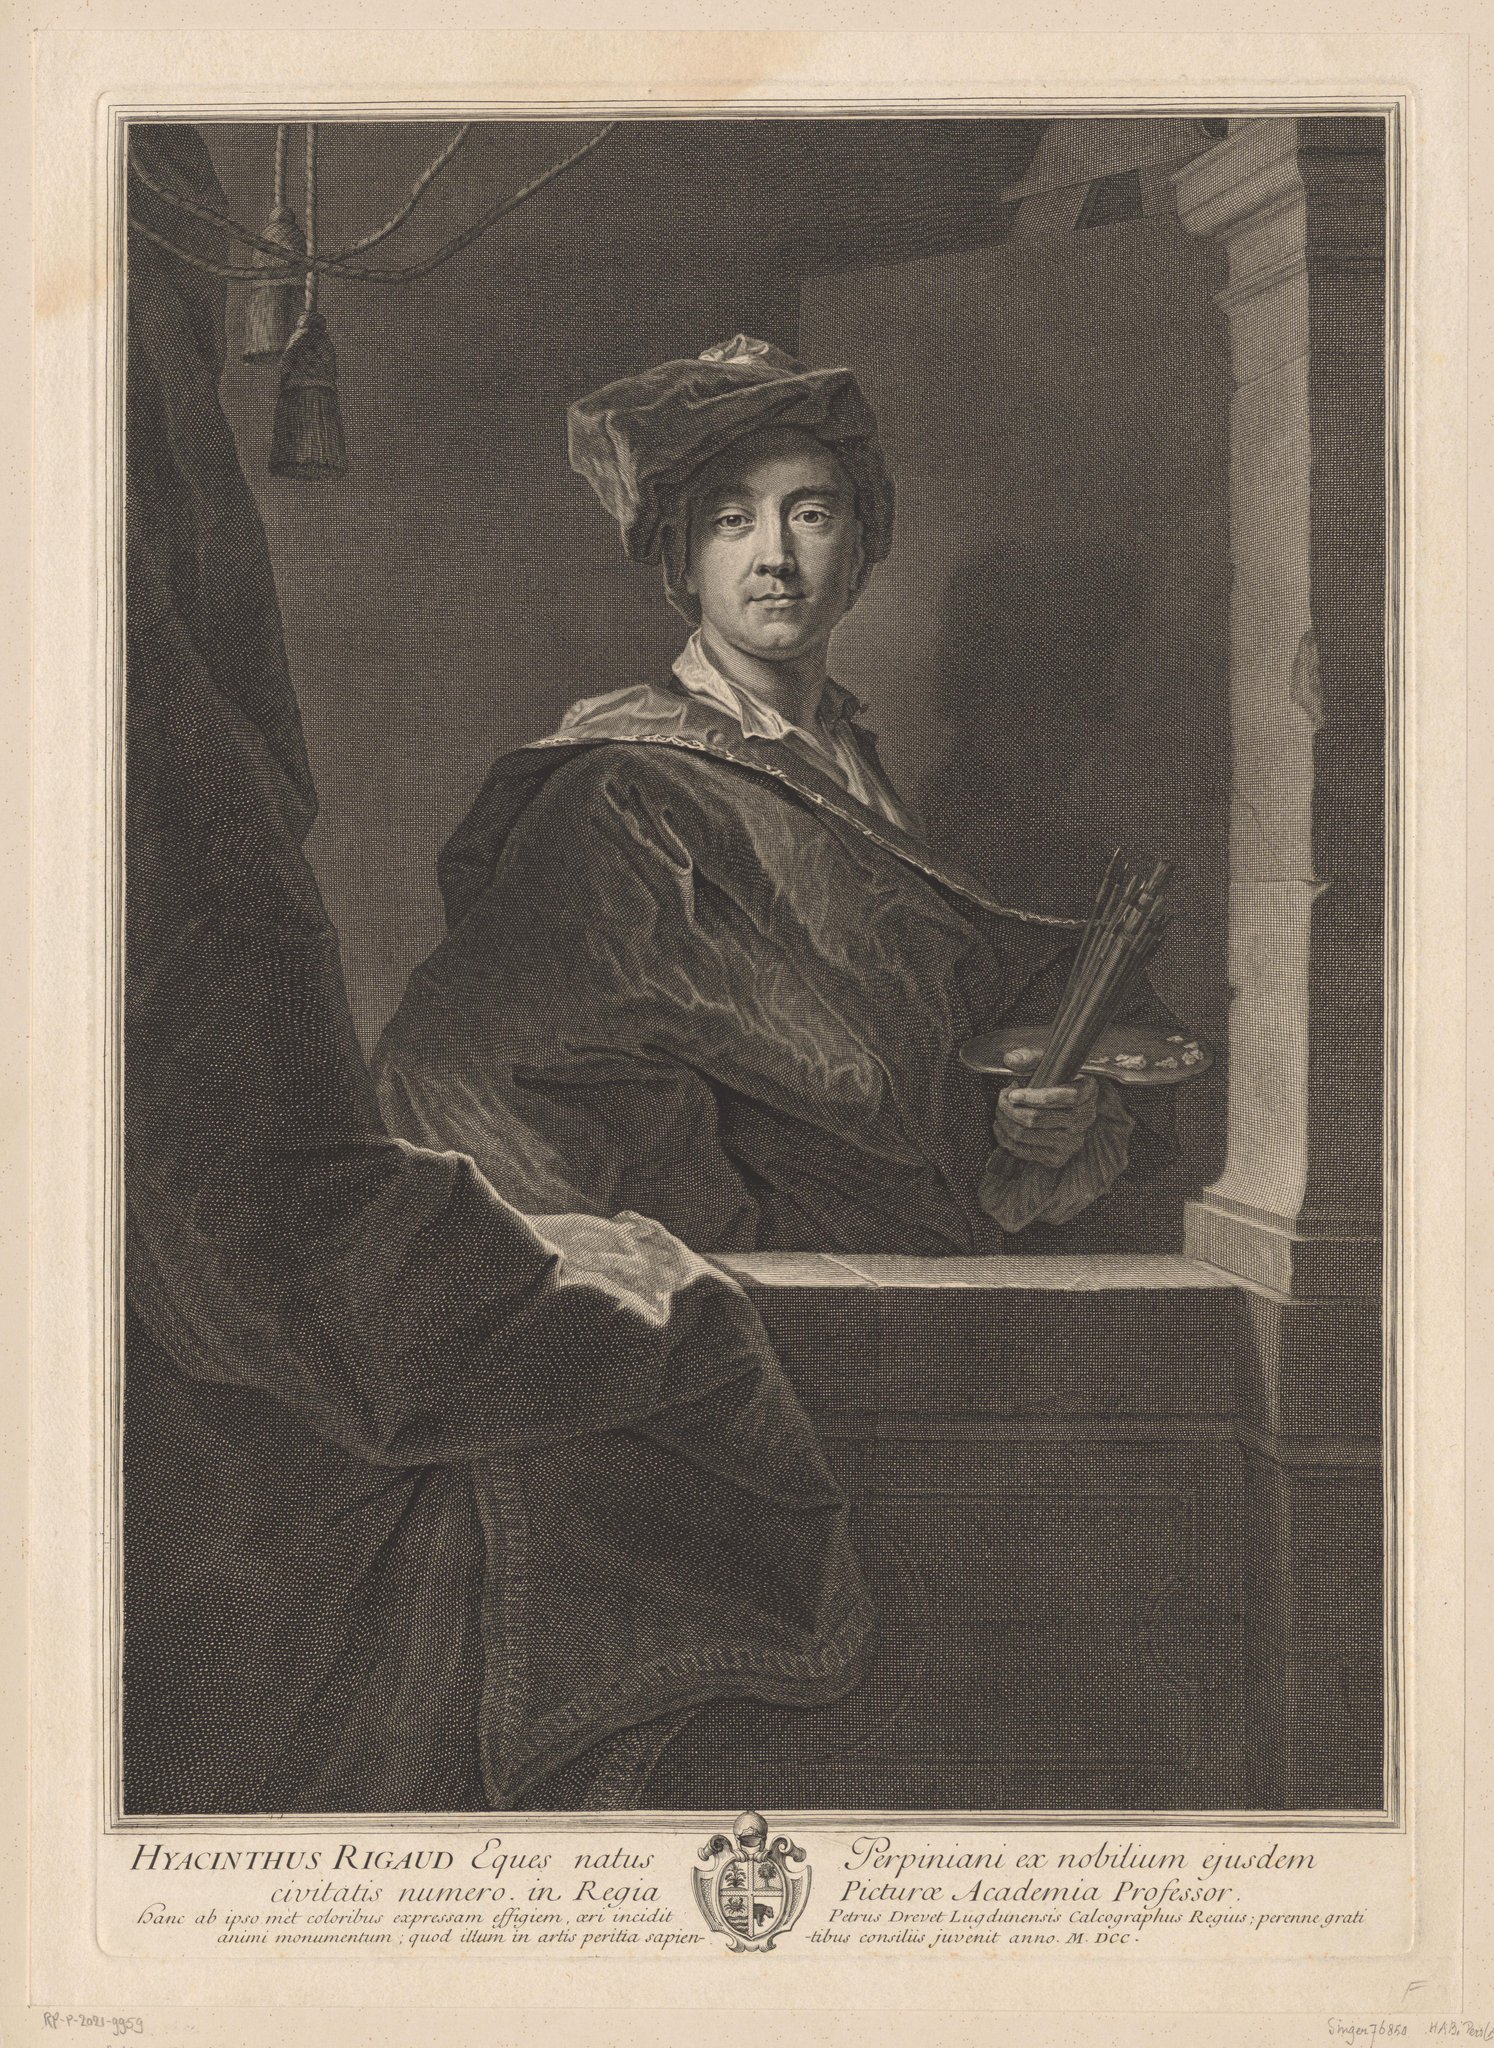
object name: print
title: Portret van Hyacinthe Rigaud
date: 1738-1773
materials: paper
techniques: engraving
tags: paris, painter, draughtsman, hyacinthe rigaud, historical persons, armorial bearing, heraldry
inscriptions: collector's mark: Lugt 2228